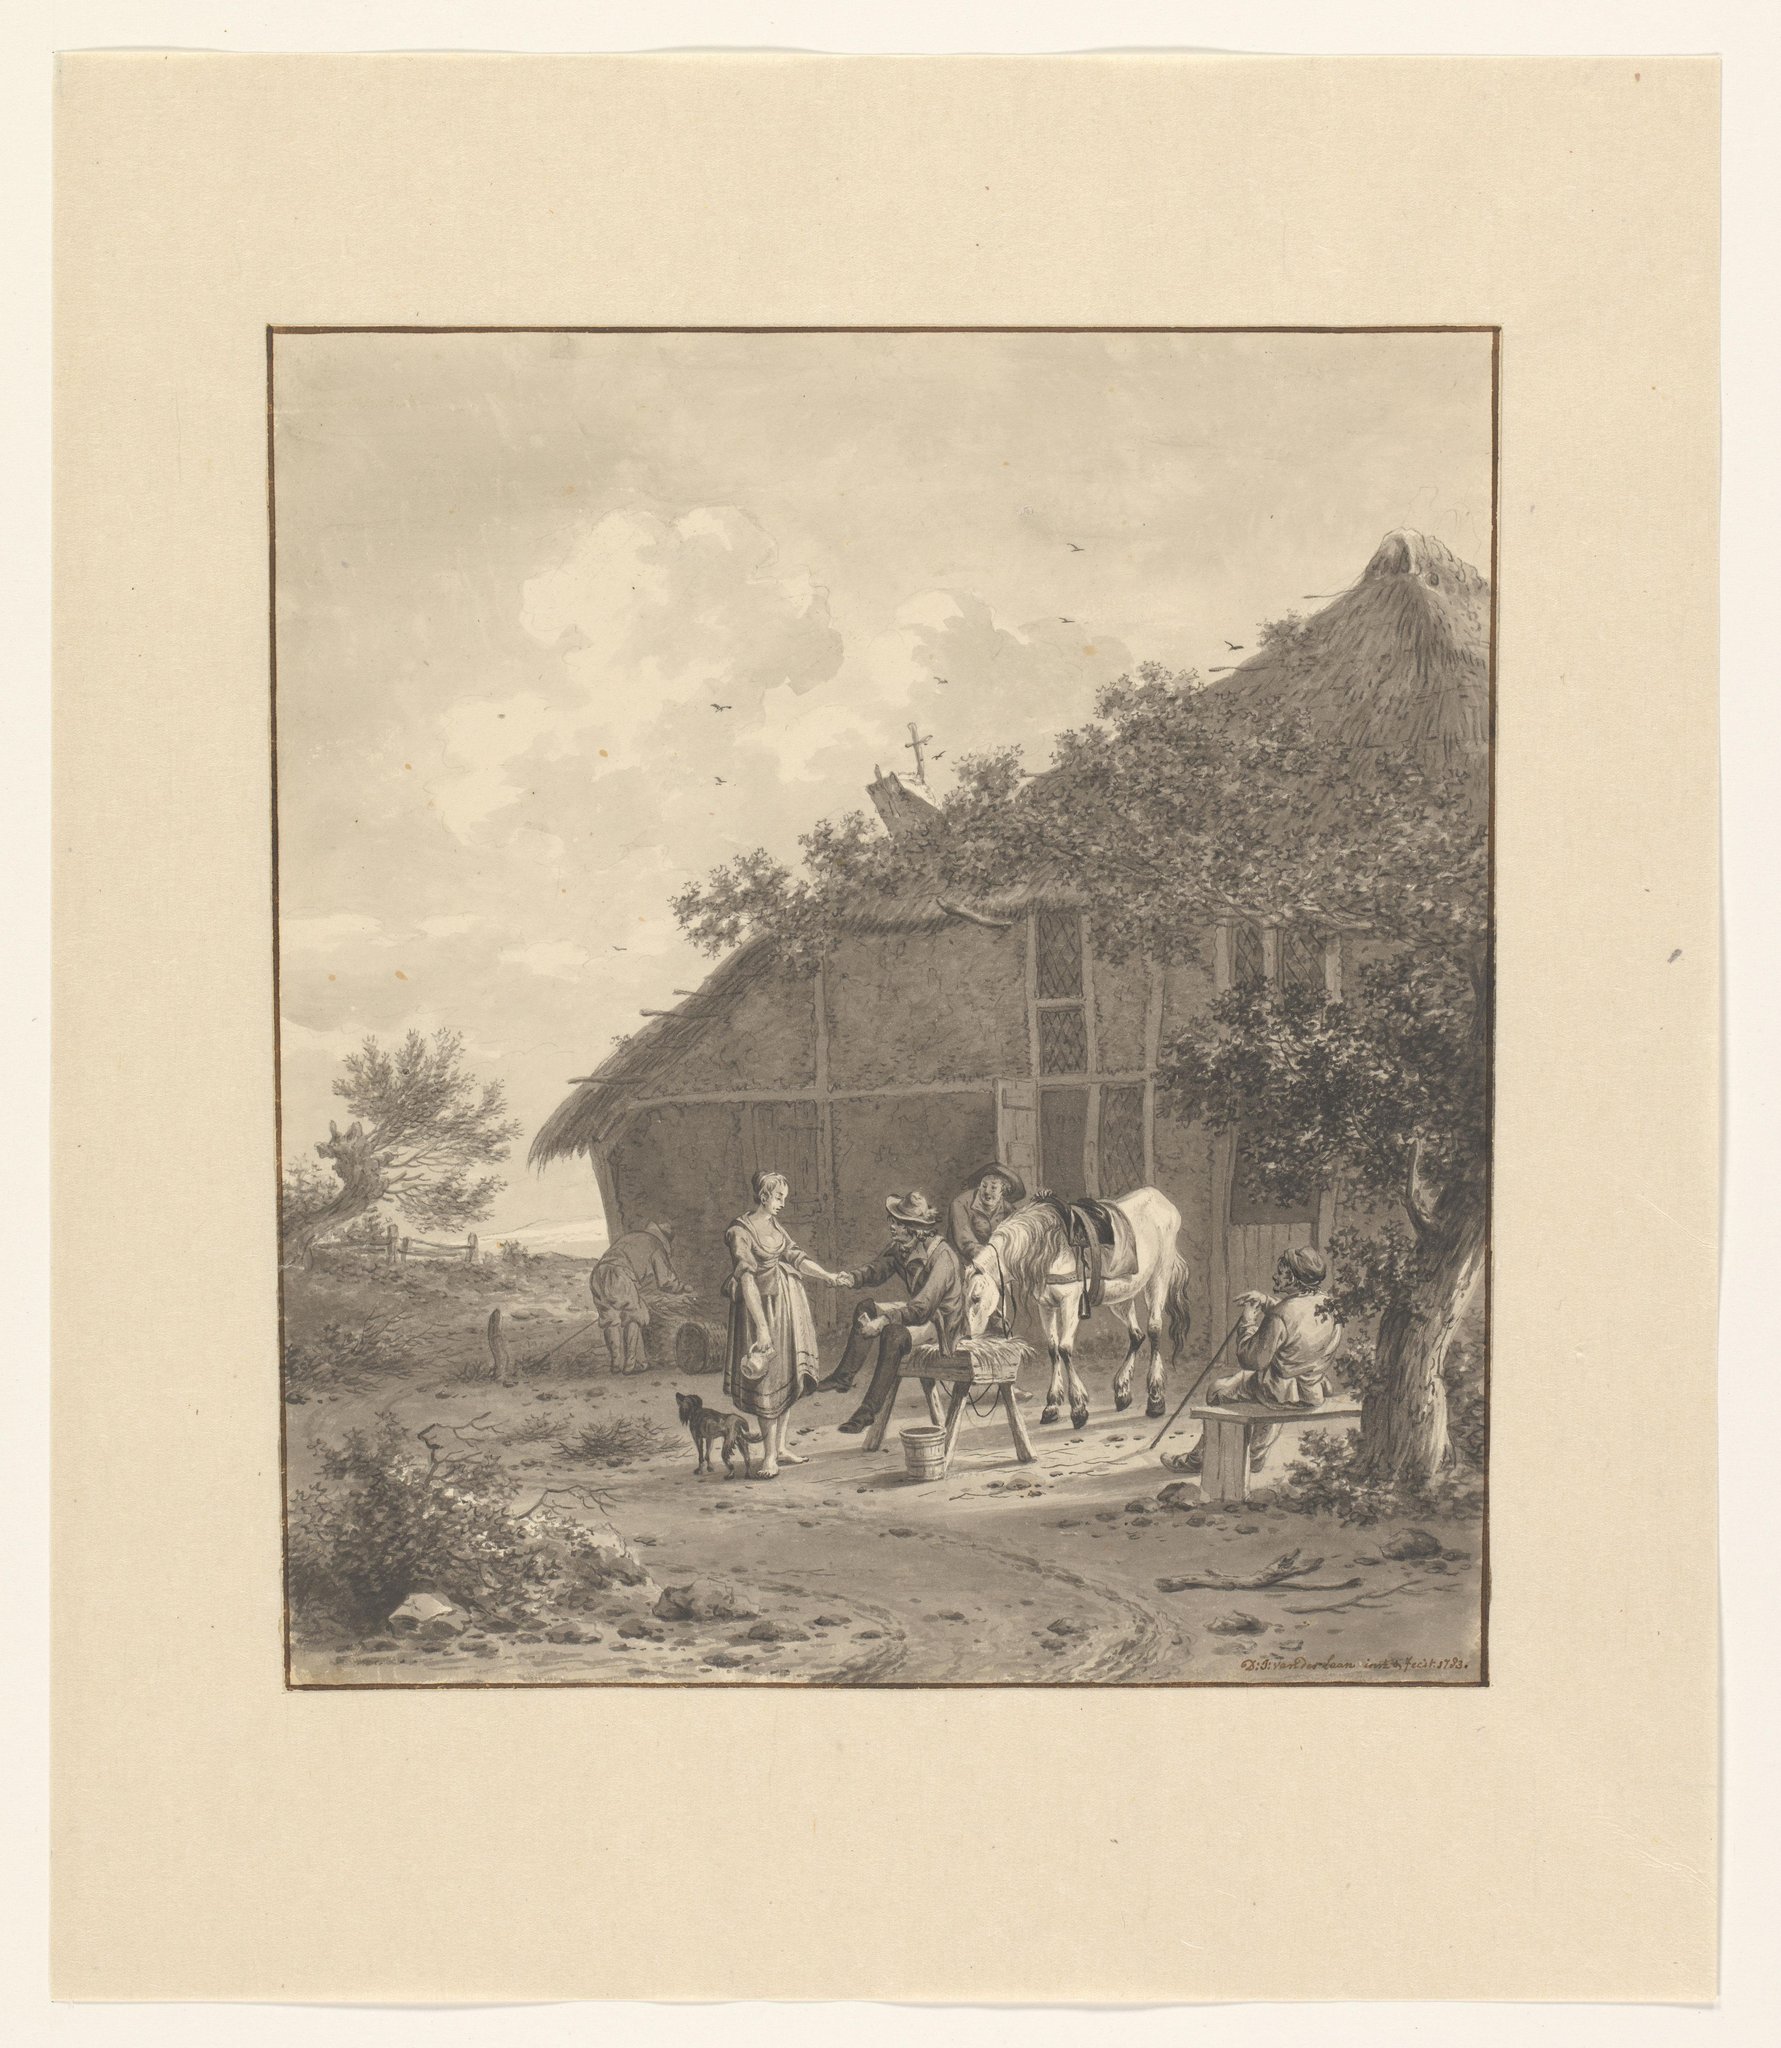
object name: drawing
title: Rustende ruiter bij herberg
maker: dirk jan van der laan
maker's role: draughtsman, painter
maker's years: 1759-1829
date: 1783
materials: chalk, paper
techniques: brush